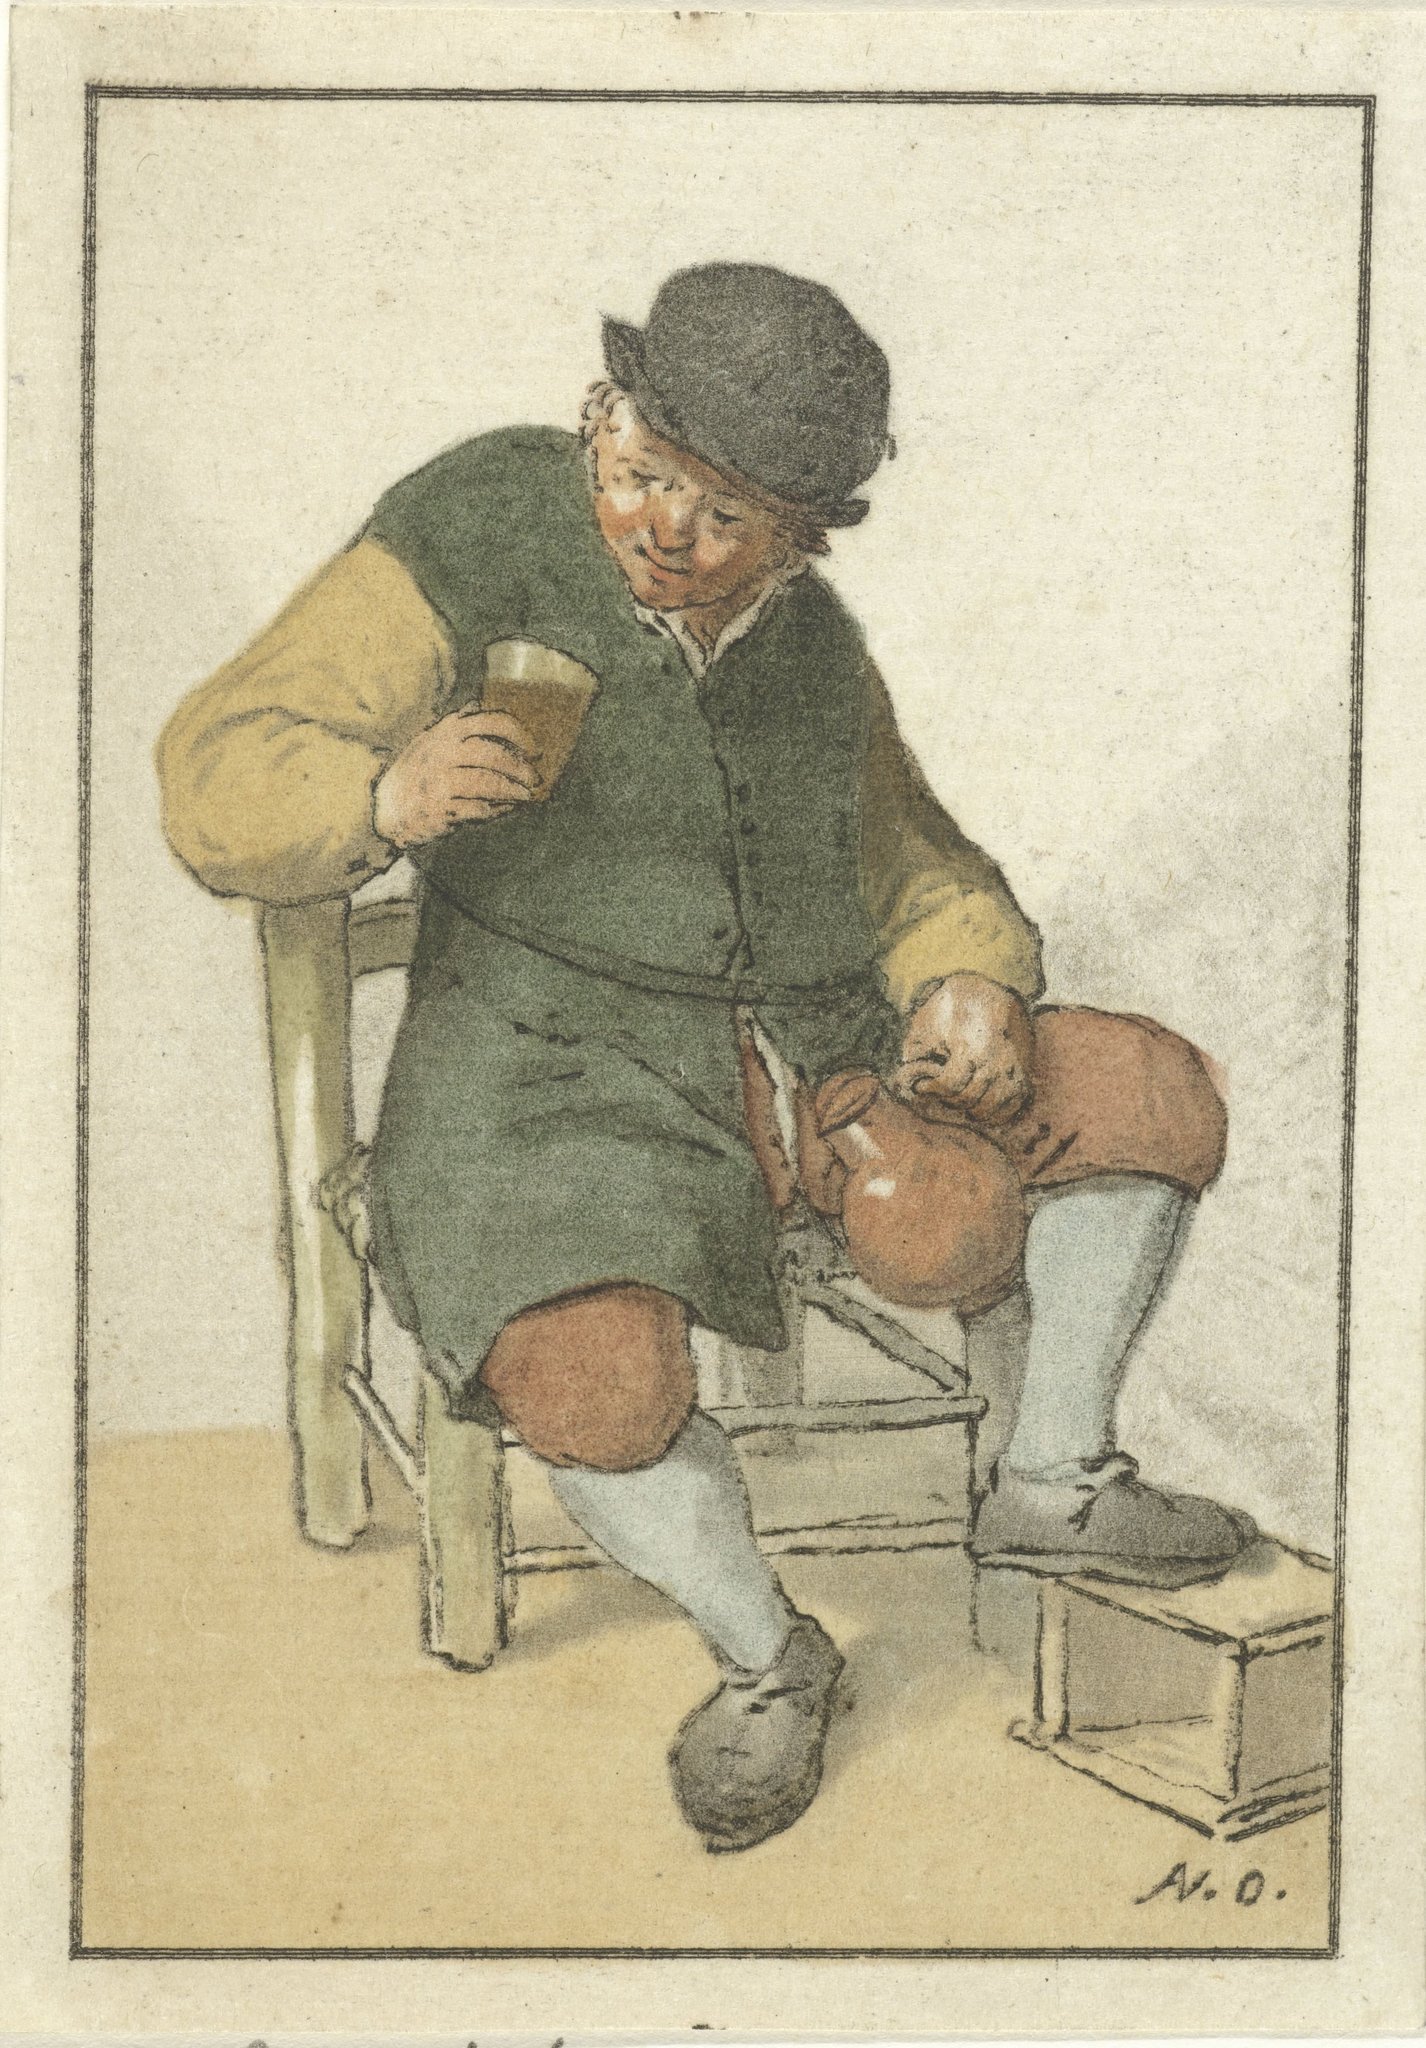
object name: print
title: Zittende boer met kruik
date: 1768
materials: paper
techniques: etching, roulette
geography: amsterdam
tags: sitting figure, jar, jug (used as drinking-vessel)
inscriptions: collector's mark: Lugt 240, inscription: ‘geschonken aan mijnen Vriend [...] Gravenhage PvAmstel / A v Ostade del ploos v AMstel JC F: 1768’, collector's mark: Lugt 2725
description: Voor deze prenttekening, 'Zittende boer met kruik', maakte Ploos van Amstel vier verschillende platen (A, B, C, en D). Er bestaan afdrukken van één, twee, drie of alle vier de platen in alle mogelijke combinaties. Zie gerelateerde objecten voor de hier gebruikte platen.